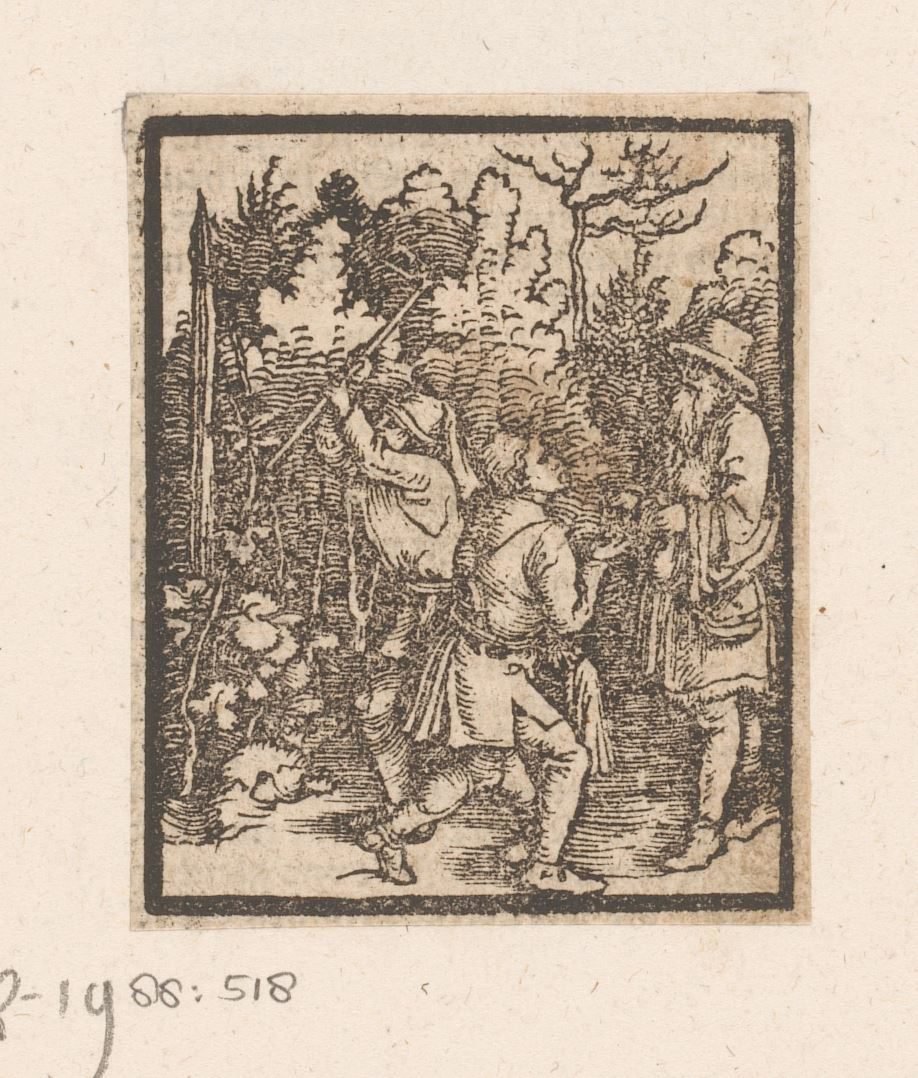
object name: print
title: Parabel van de werkers in de wijngaarde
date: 1536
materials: paper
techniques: woodcut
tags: the labourers in the vineyard ~ parable of christ (matthew 20:1-16)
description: Prent afkomstig uit: Evangelia und Epistel. Neurenberg: Hans Guldenmund, 1536.